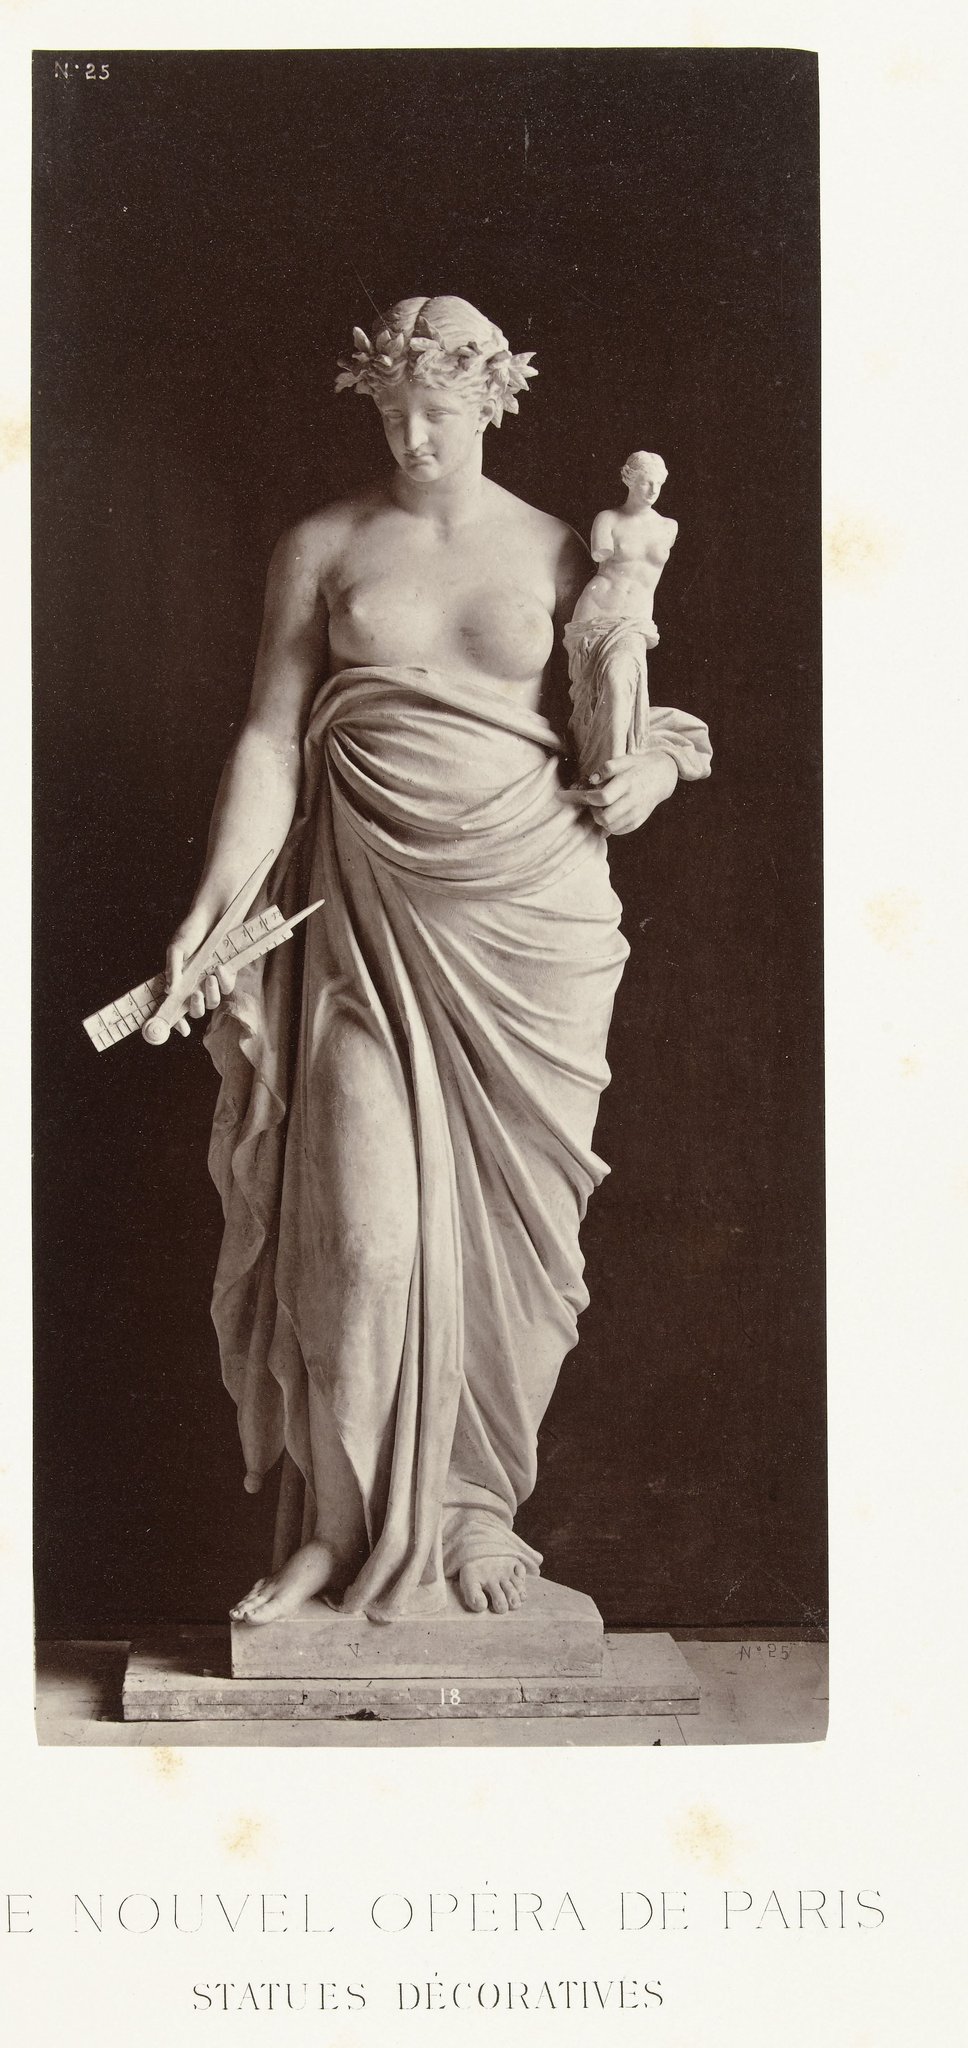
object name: photograph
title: Marmeren beeld van een vrouw met in haar linkerhand een beeld, in haar rechterhand draagt zij een passer en een liniaal.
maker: louis-emile durandelle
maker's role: fotograaf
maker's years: 1839-1917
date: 1878-1881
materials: photographic support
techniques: albumen print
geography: paris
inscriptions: number: ‘25’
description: bij boek in Bibliotheek RMA, Zie Frizot, pp. 217-223, vgl G. Vicaire, Manuel de l'amateur de livres du XIXe siècle, vol. 3, column 870.